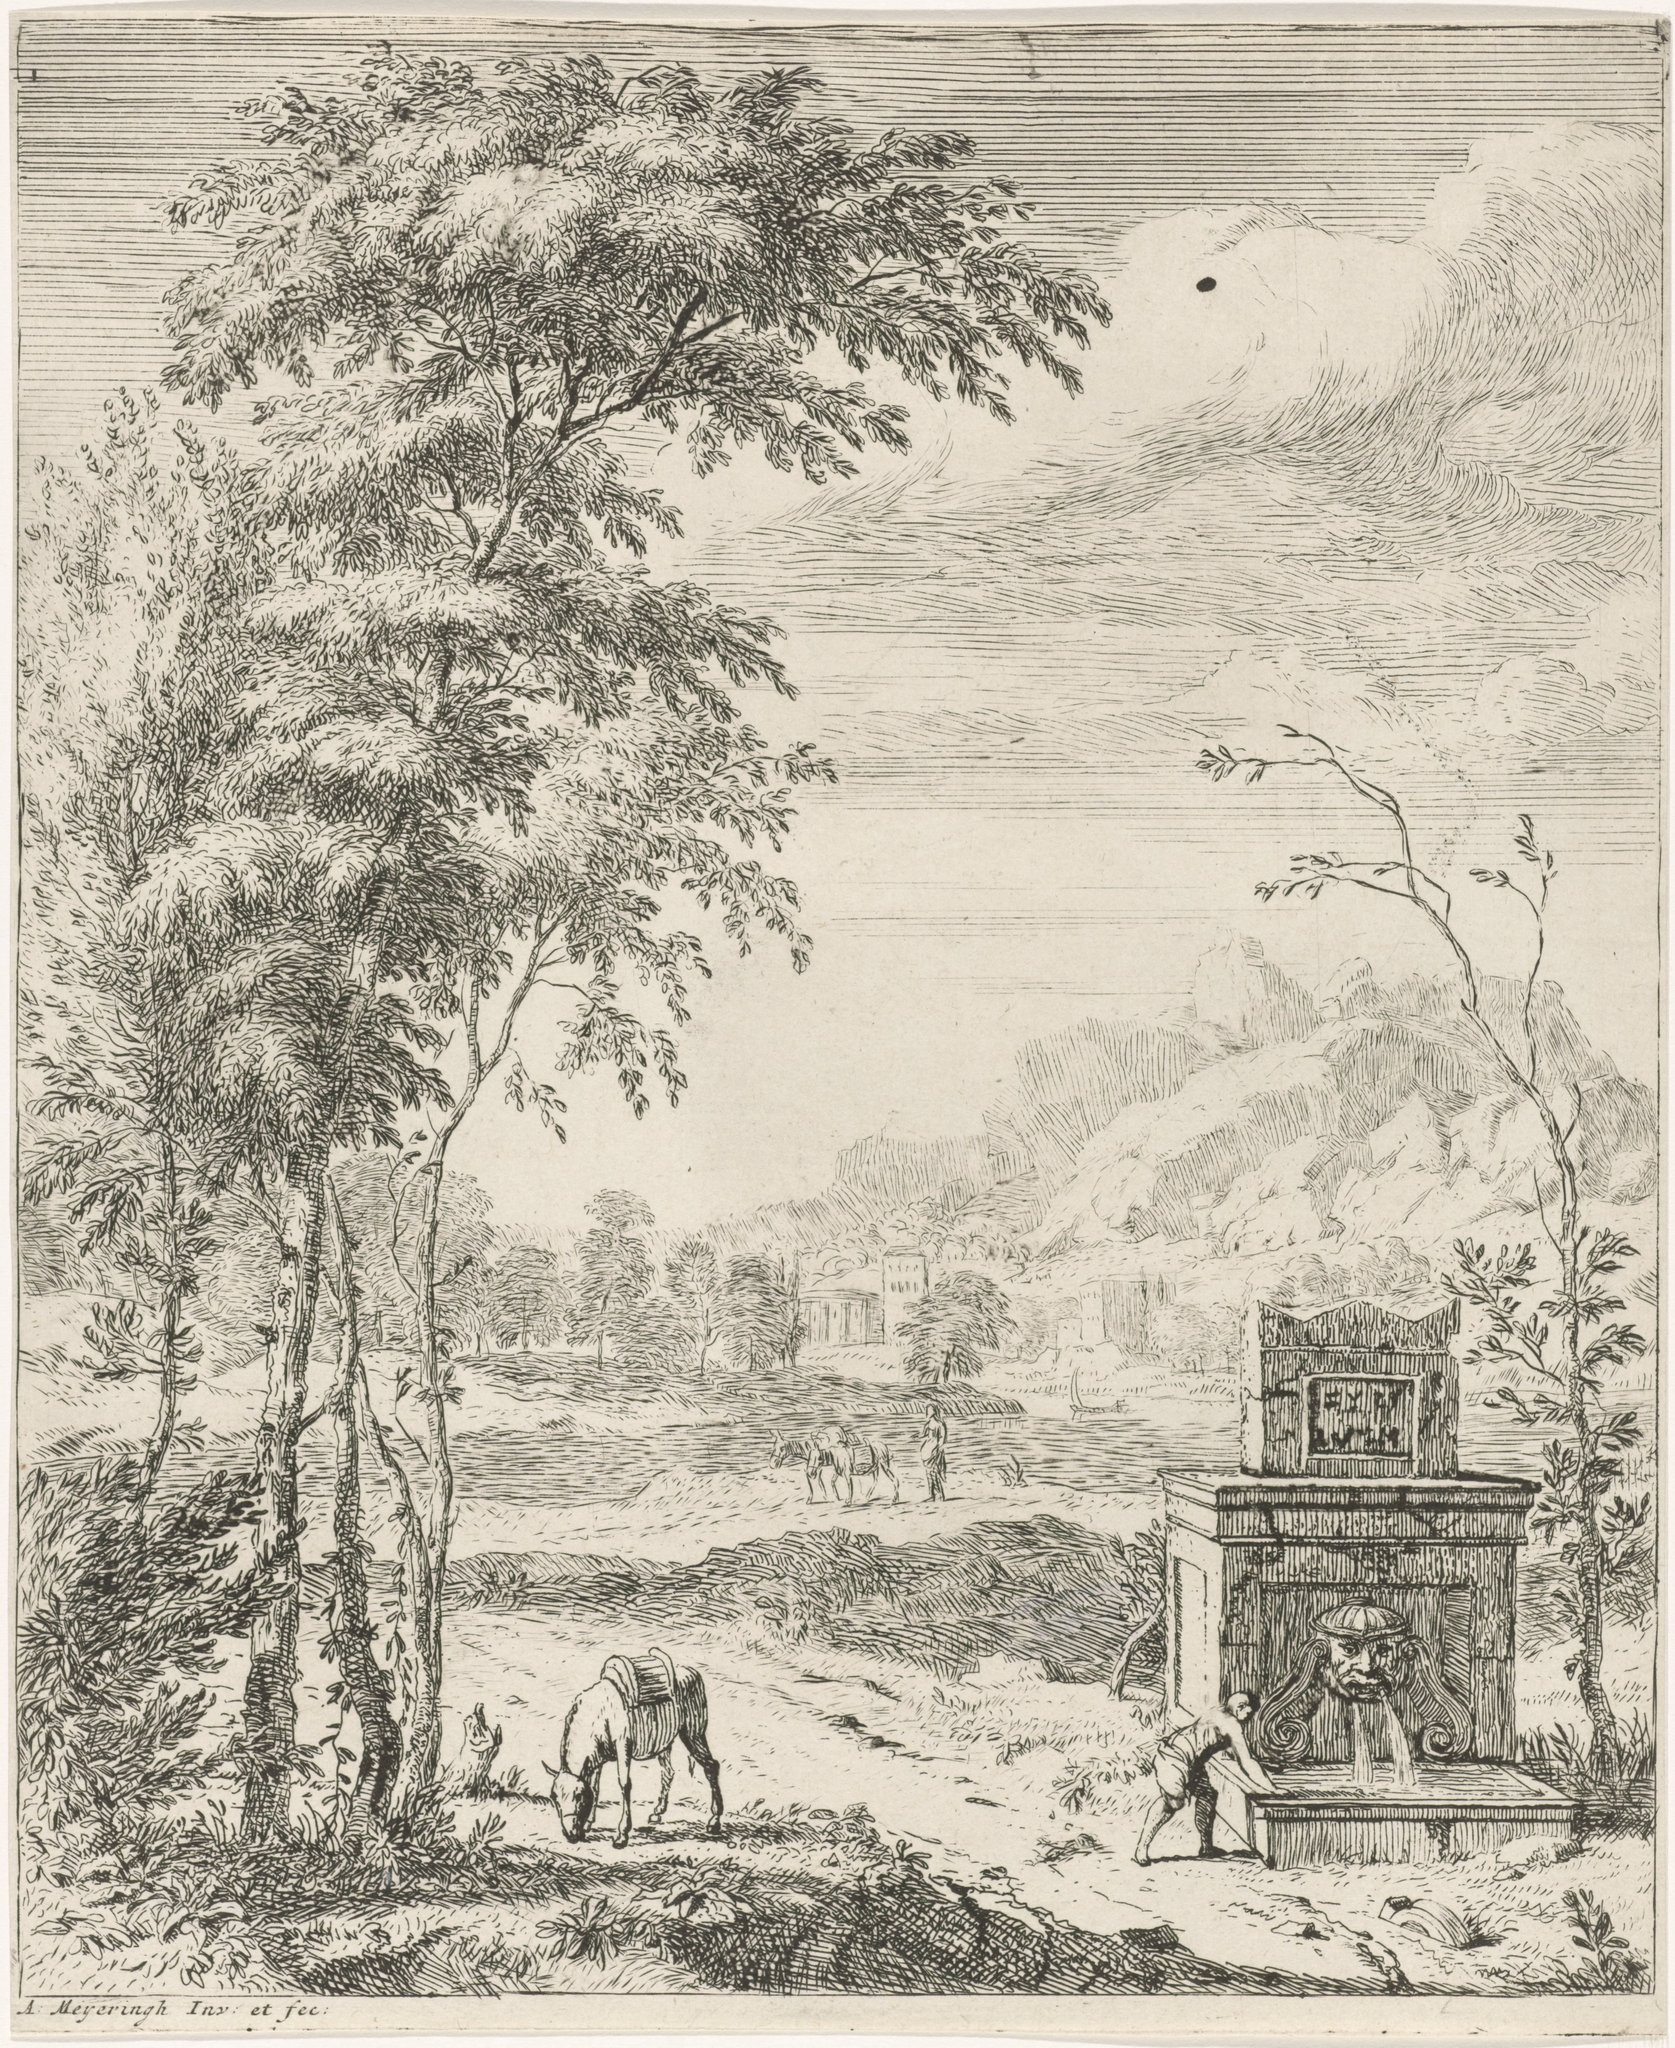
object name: print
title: Landschappen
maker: albert meyering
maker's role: draughtsman, print maker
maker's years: 1645-1714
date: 1695-1714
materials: paper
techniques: etching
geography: amsterdam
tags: ass, donkey, utilitarian, public pump or water fountain, mountains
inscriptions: collector's mark: Lugt 2228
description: Landschap met een fontein, waarbij het water uit de muur in een bassin stroomt. Daarbij staat een man. Links een grazende ezel en op de achtergrond bergen.